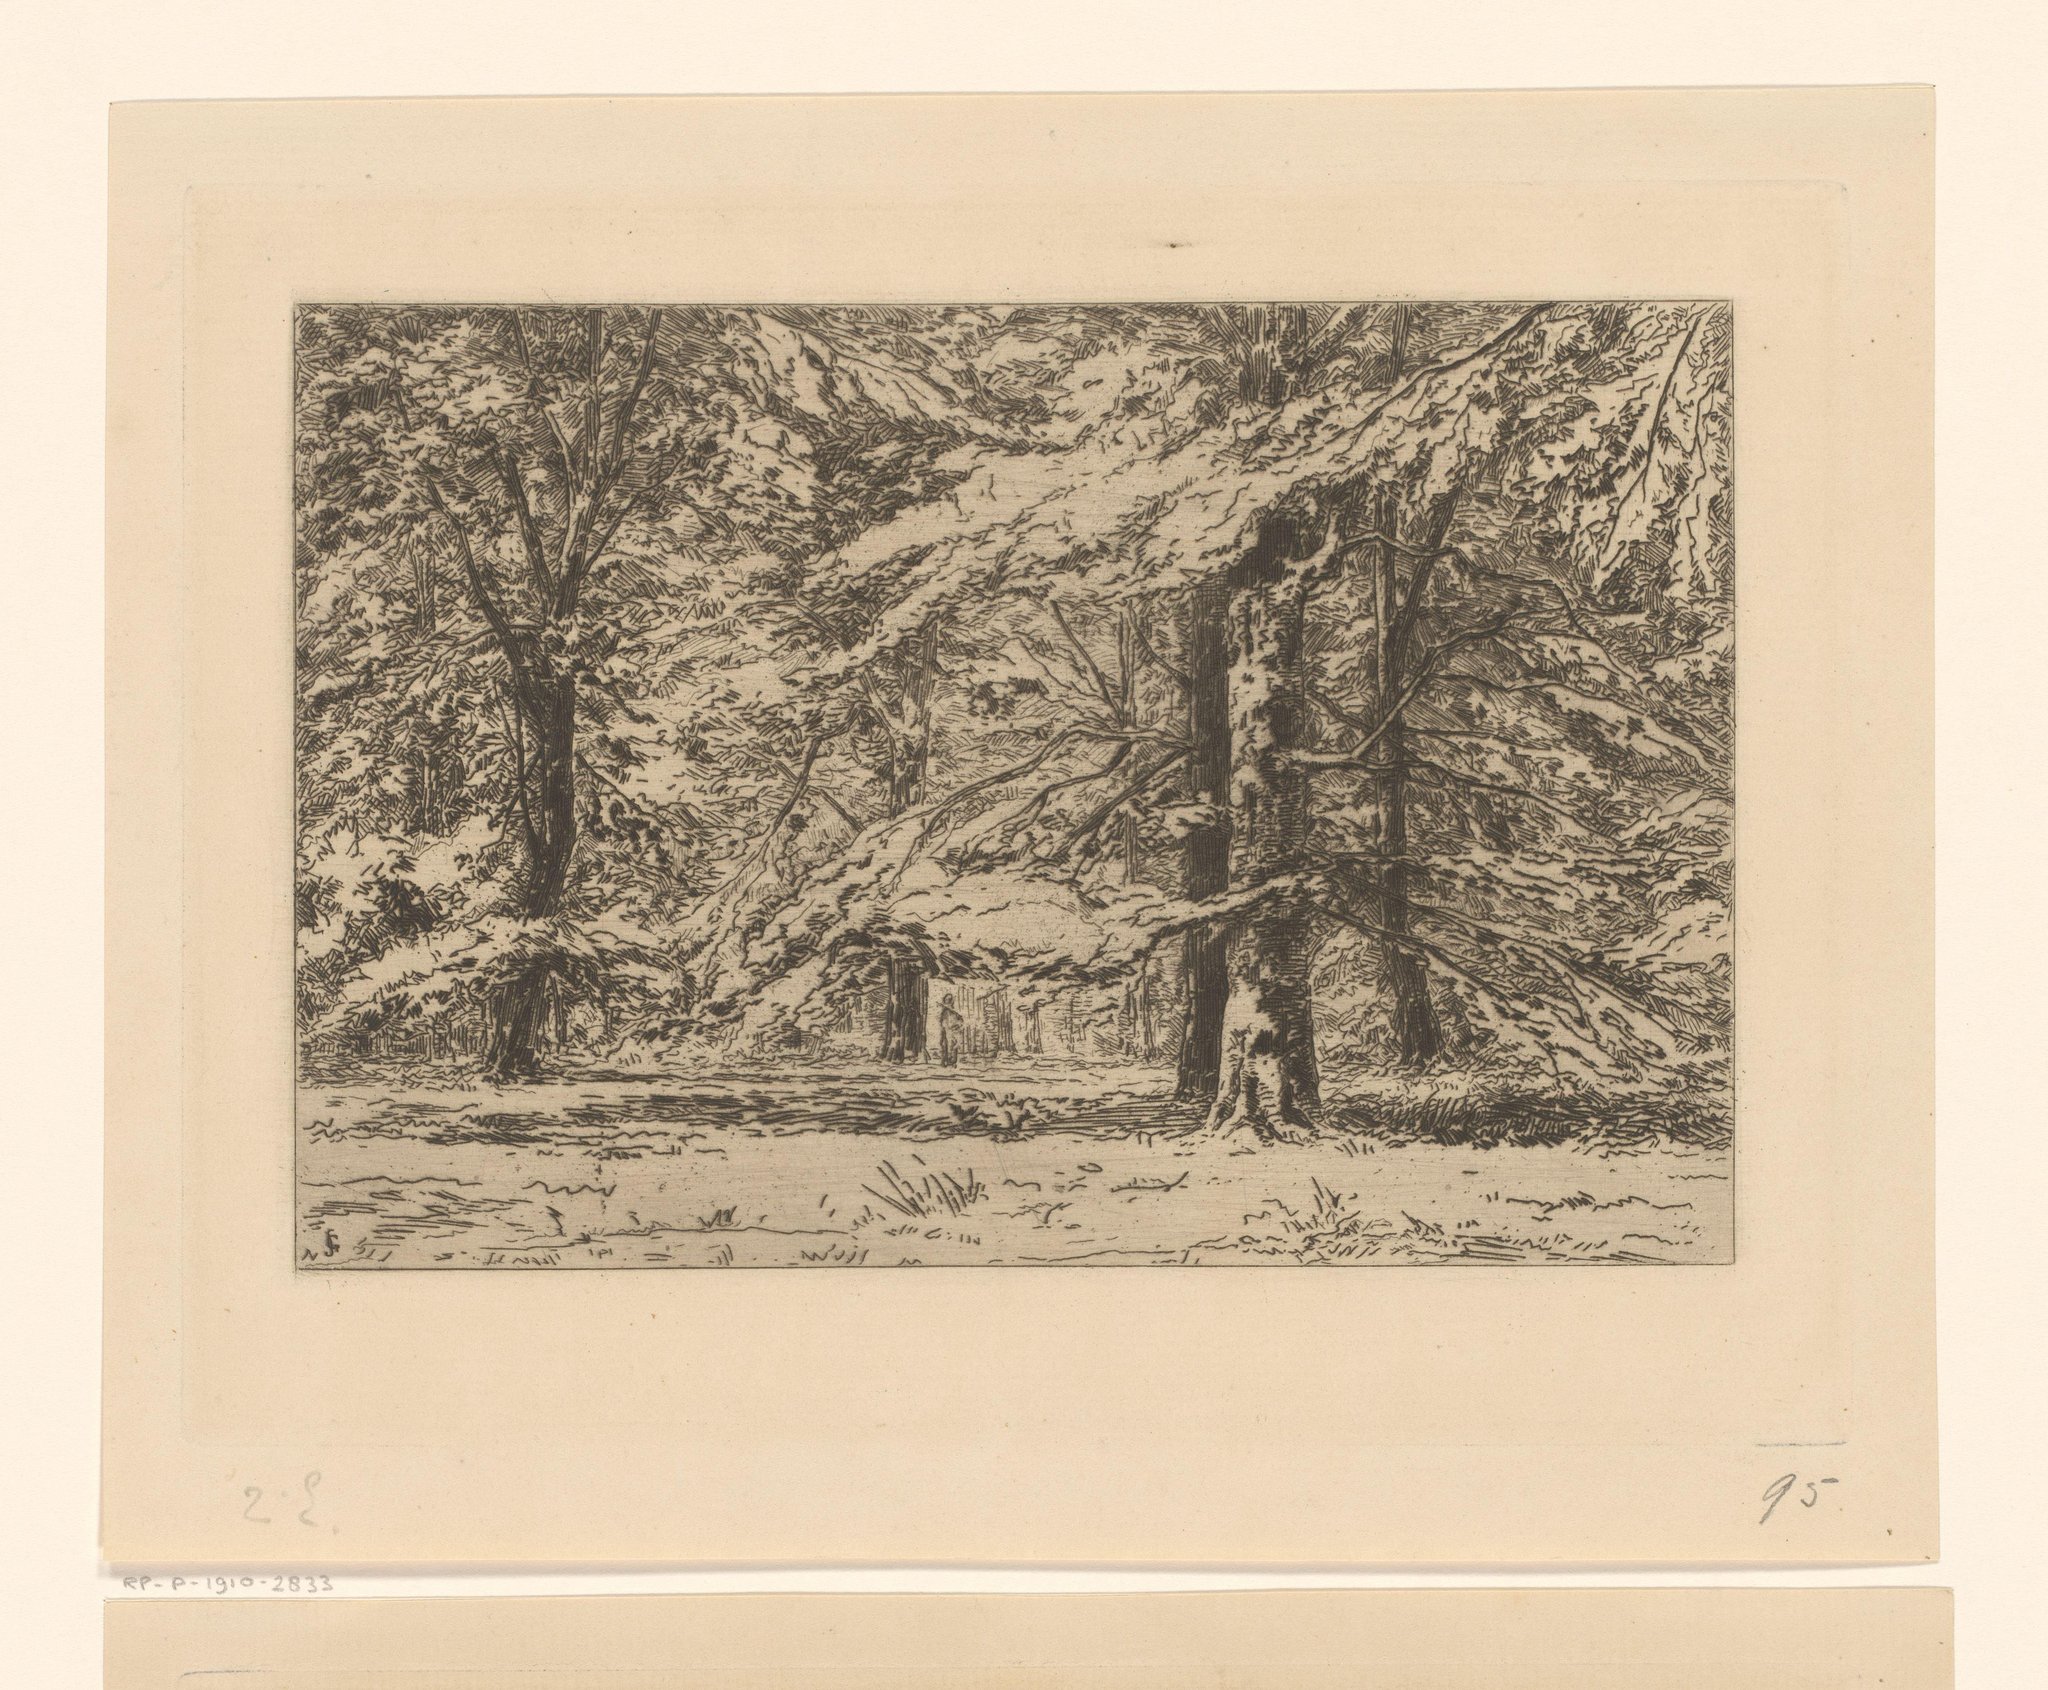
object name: print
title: Bomen op landgoed Kasteel Groeneveld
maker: carel nicolaas storm van s-gravesande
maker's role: draughtsman, print maker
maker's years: 1841-1924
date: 1877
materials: paper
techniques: etching, intaglio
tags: forest, wood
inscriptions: collector's mark: Lugt 2228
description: In het midden staat een figuur naast een boom.